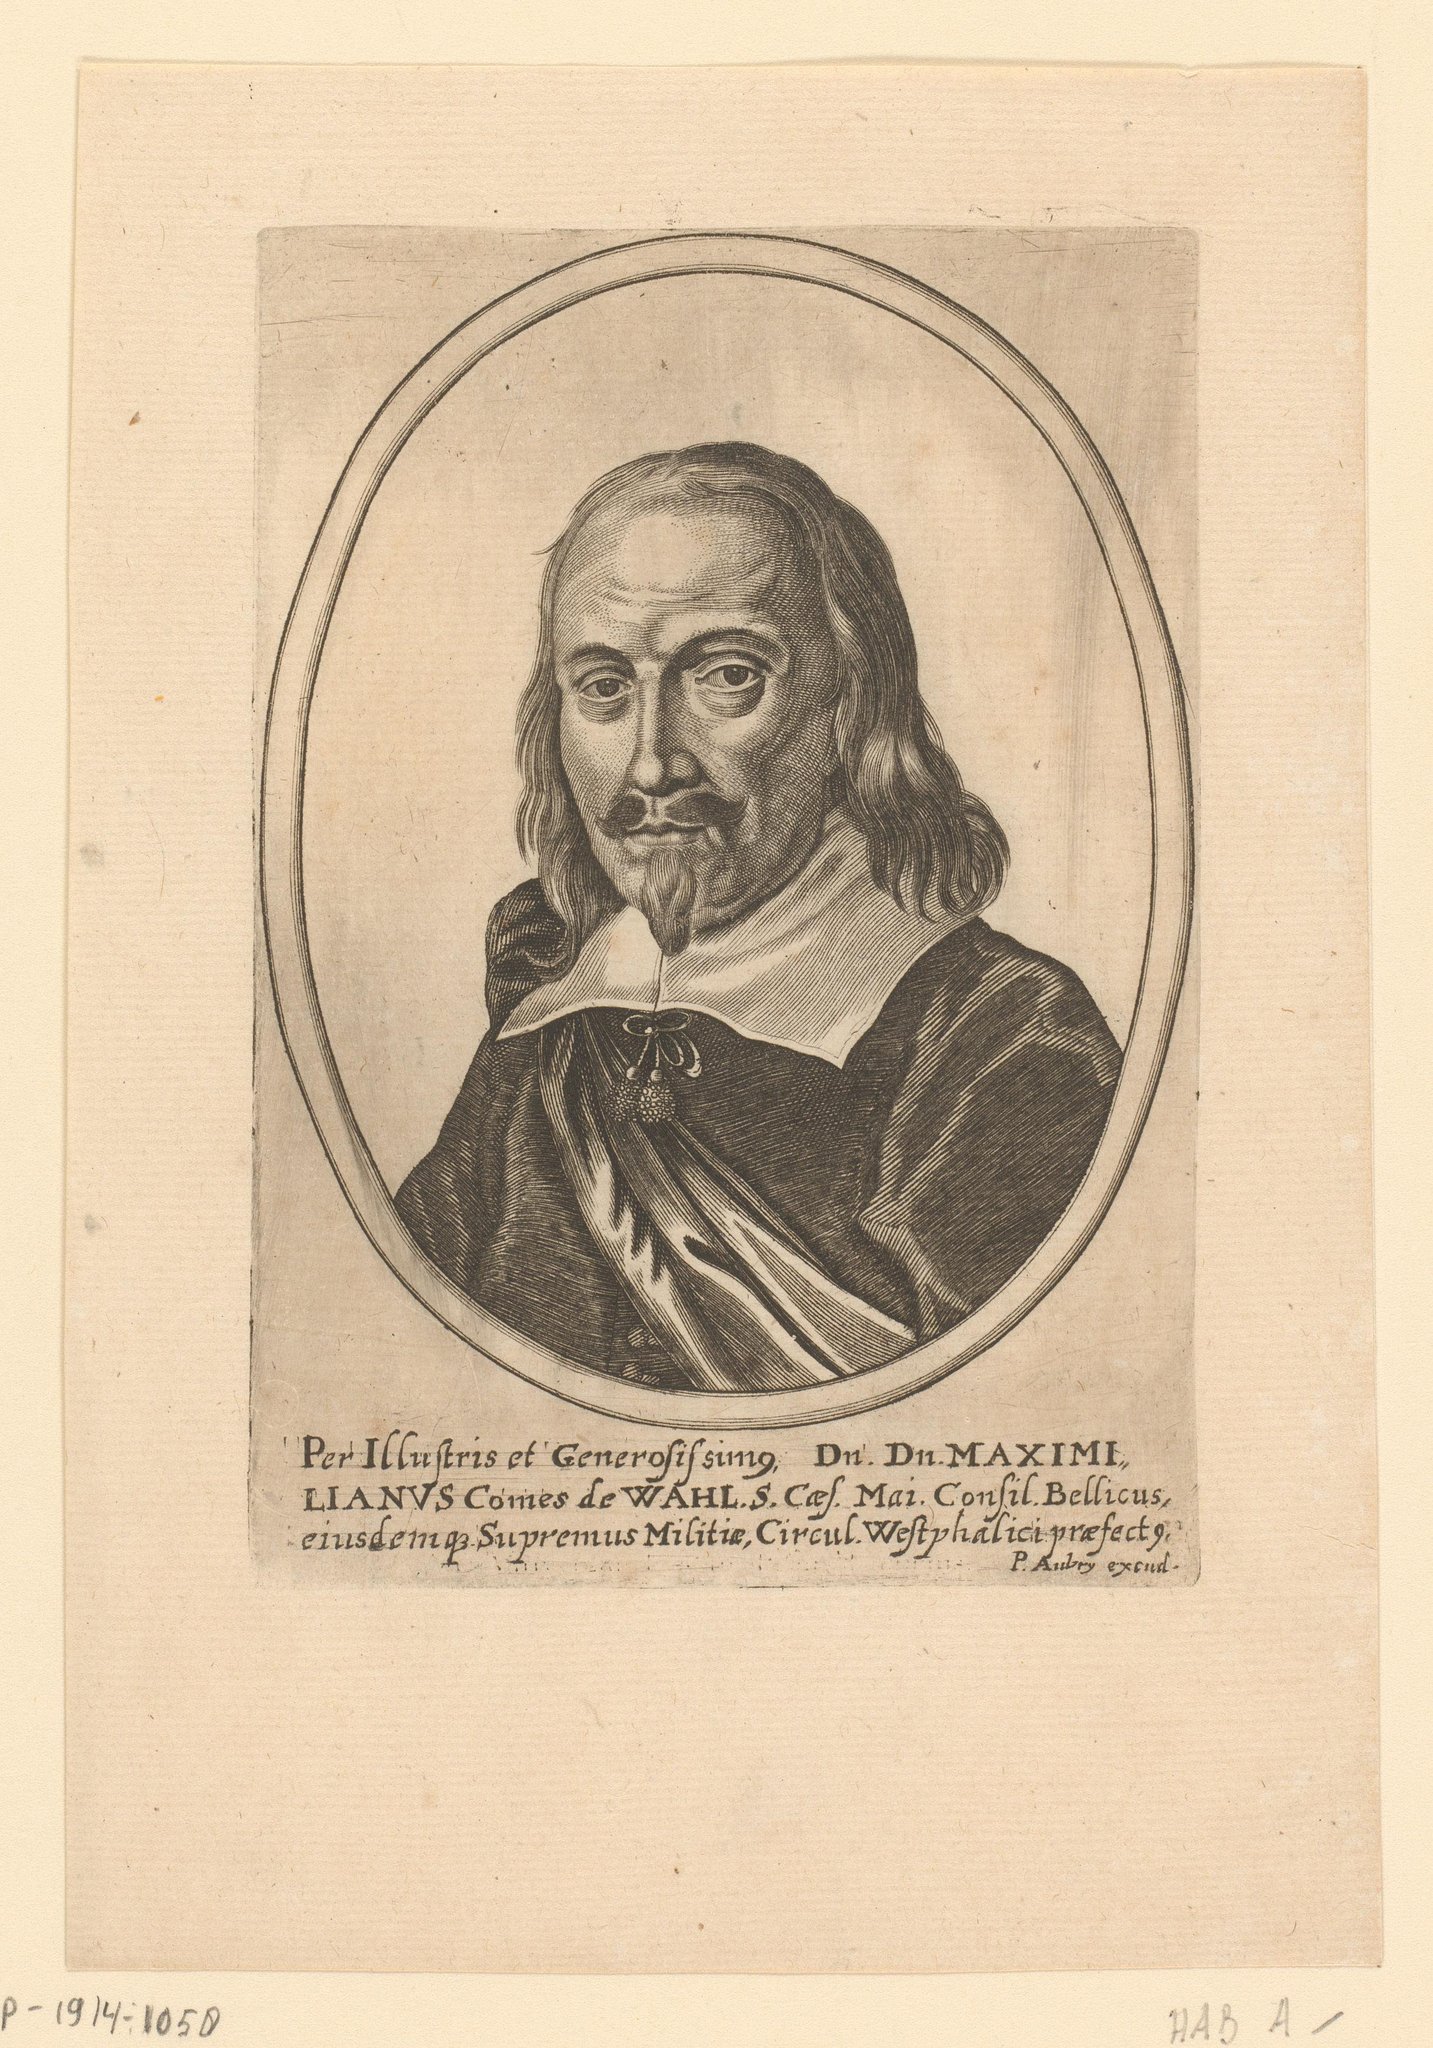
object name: print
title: Portretten van afgevaardigden bij de Vrede van Westfalen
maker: Anonymous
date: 1648-1650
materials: paper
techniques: engraving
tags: earl, historical persons, nobility and patriciate; chivalry, knighthood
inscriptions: collector's mark: Lugt 2228